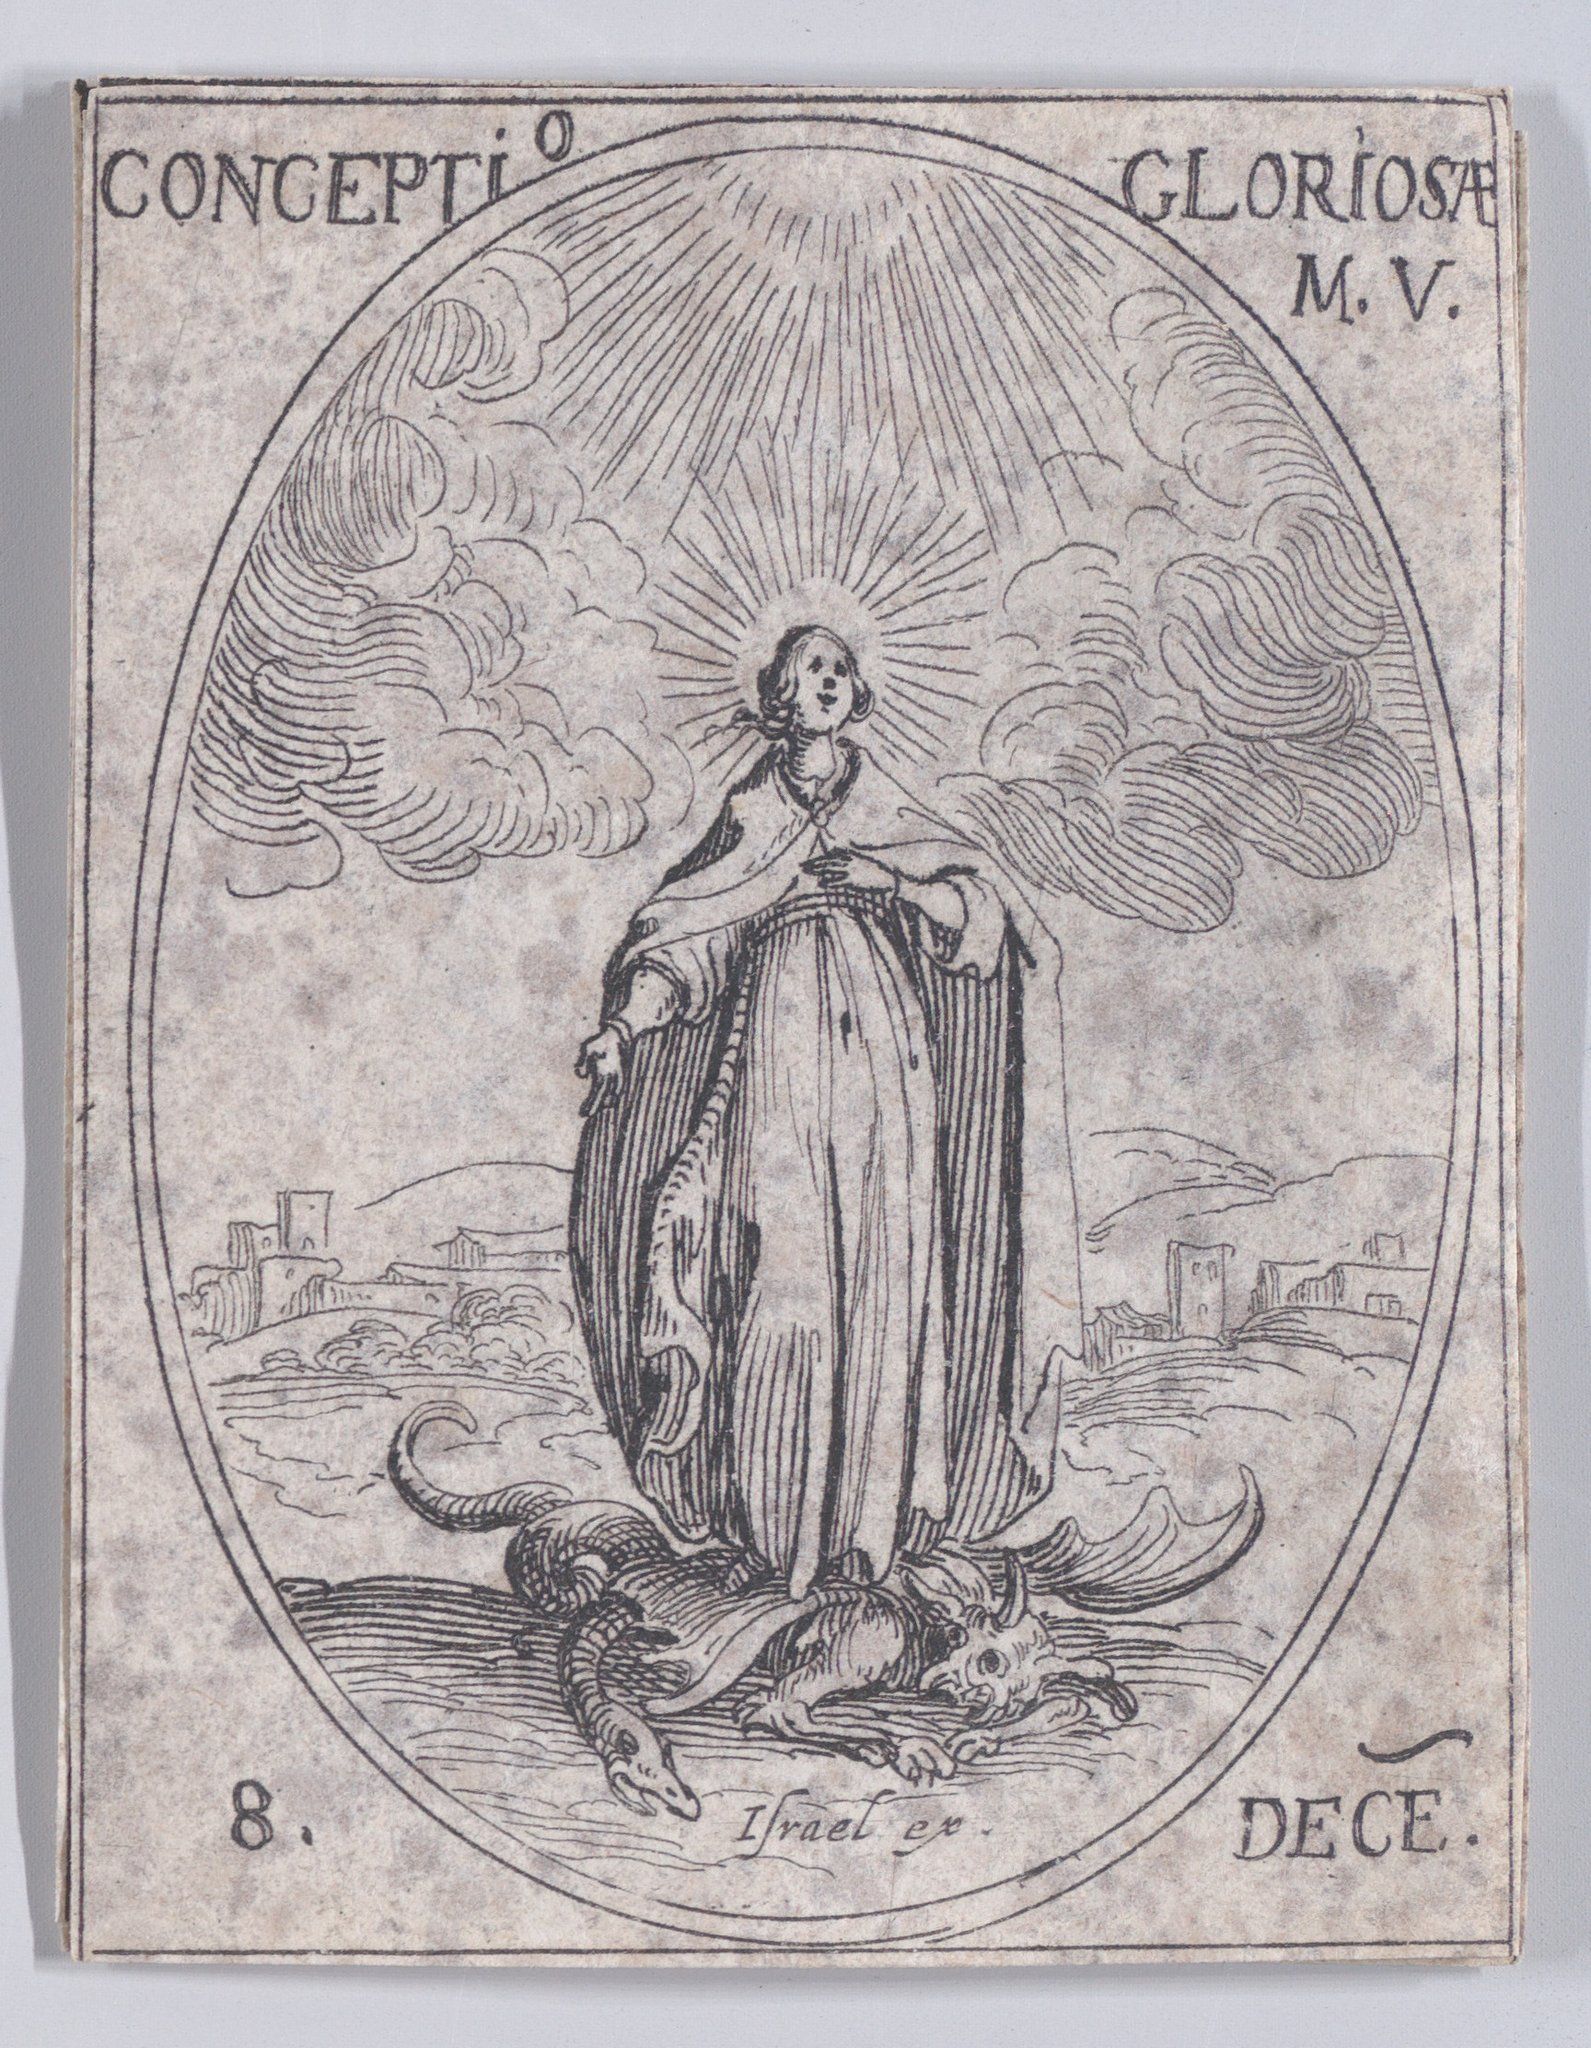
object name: print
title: La Conception Glorieuse de la Se. Vierge (The Immaculate Conception), December 8th, from "Les Images De Tous Les Saincts et Saintes de L'Année" (Images of All of the Saints and Religious Events of the Year)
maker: jacques callot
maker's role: artist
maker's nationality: french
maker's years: 1592-1635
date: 1636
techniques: etching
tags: virgin mary